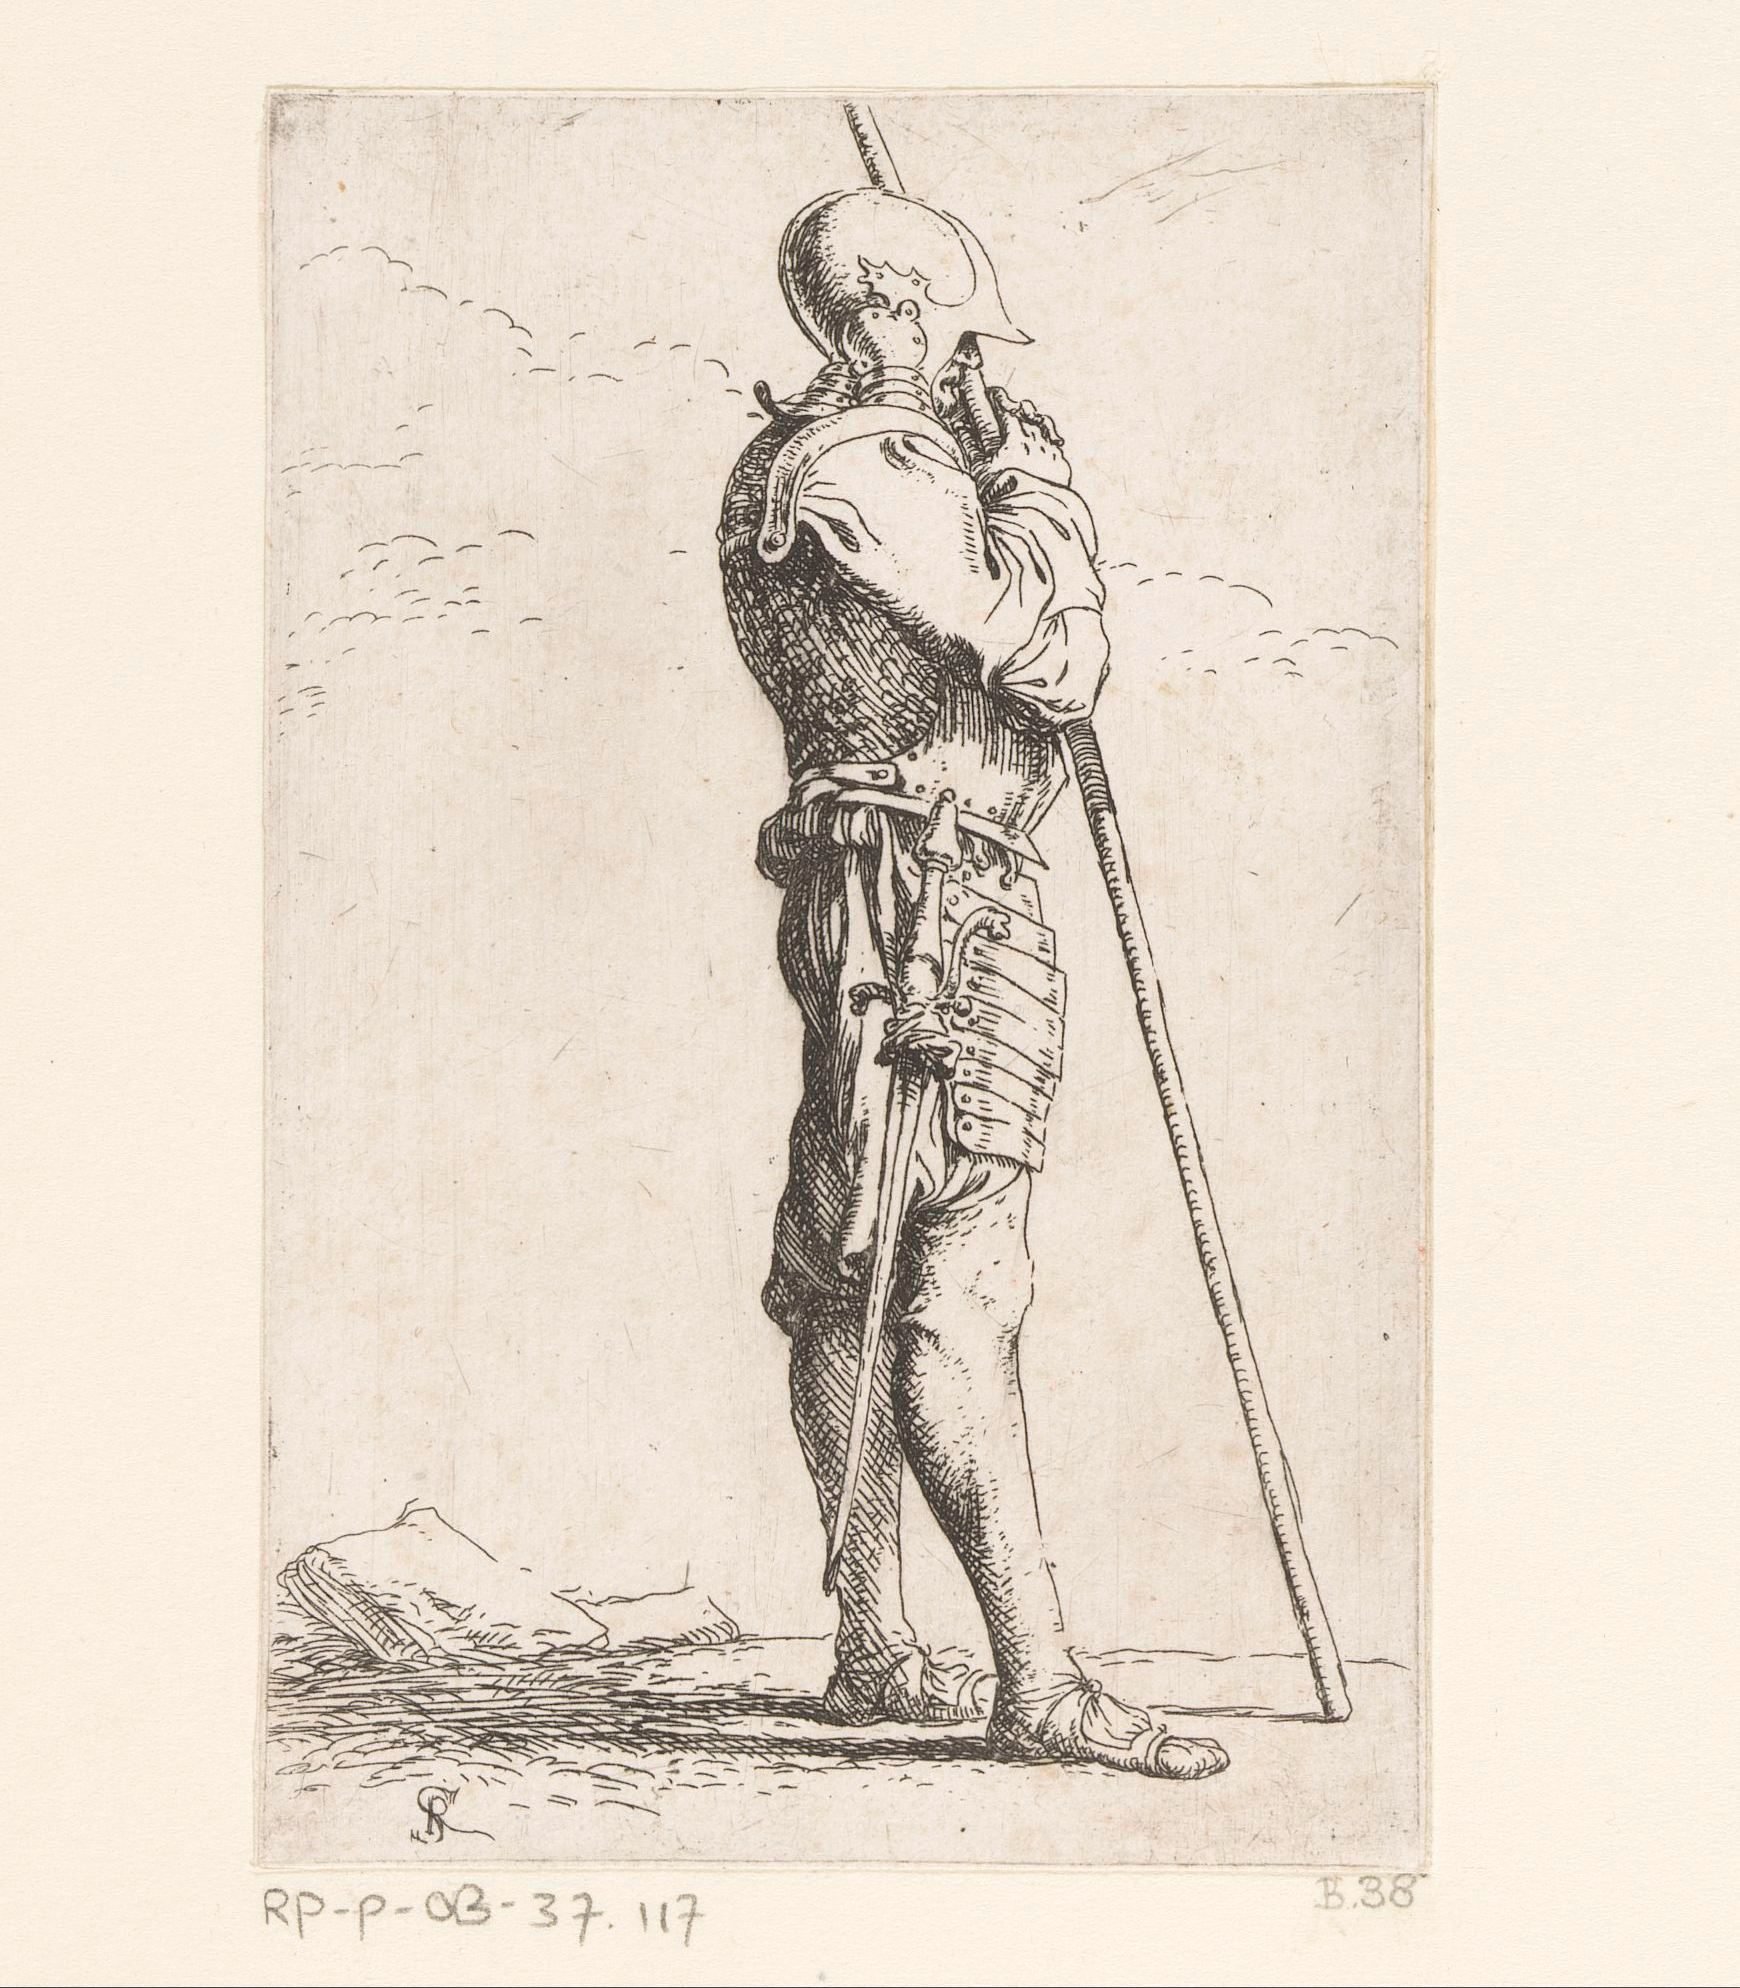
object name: print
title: Kleine figuren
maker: salvator rosa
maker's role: draughtsman, painter, print maker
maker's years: 1615-1673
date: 1656-1657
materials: paper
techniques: etching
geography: italy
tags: walking-stick, staff, hacking and thrusting weapons: sword, the soldier; the soldier's life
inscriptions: number: ‘[...]’, collector's mark: Lugt 240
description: Prent spiegelbeeldig naar een tekening die zich eens bevond in de collectie van Ladislao Odescalchi te Rome. De tekening werd in 1976 geveild te Londen. Deze prent maakt deel uit van de serie 'Figurine', bestaande uit een titelprent en 80 prenten van klein formaat met voorstellingen van mannelijke en vrouwelijke figuren. Rosa produceerde de serie waarschijnlijk gedurende de jaren 1656 en 1657.